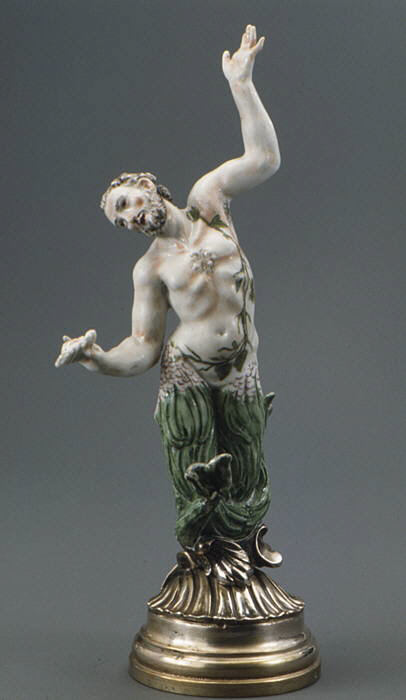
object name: figure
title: Merman (one of six)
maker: doccia porcelain manufactory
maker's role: manufactory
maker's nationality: italian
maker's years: 1737-1896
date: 1750-1755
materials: hard paste porcelain, silver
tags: mermen